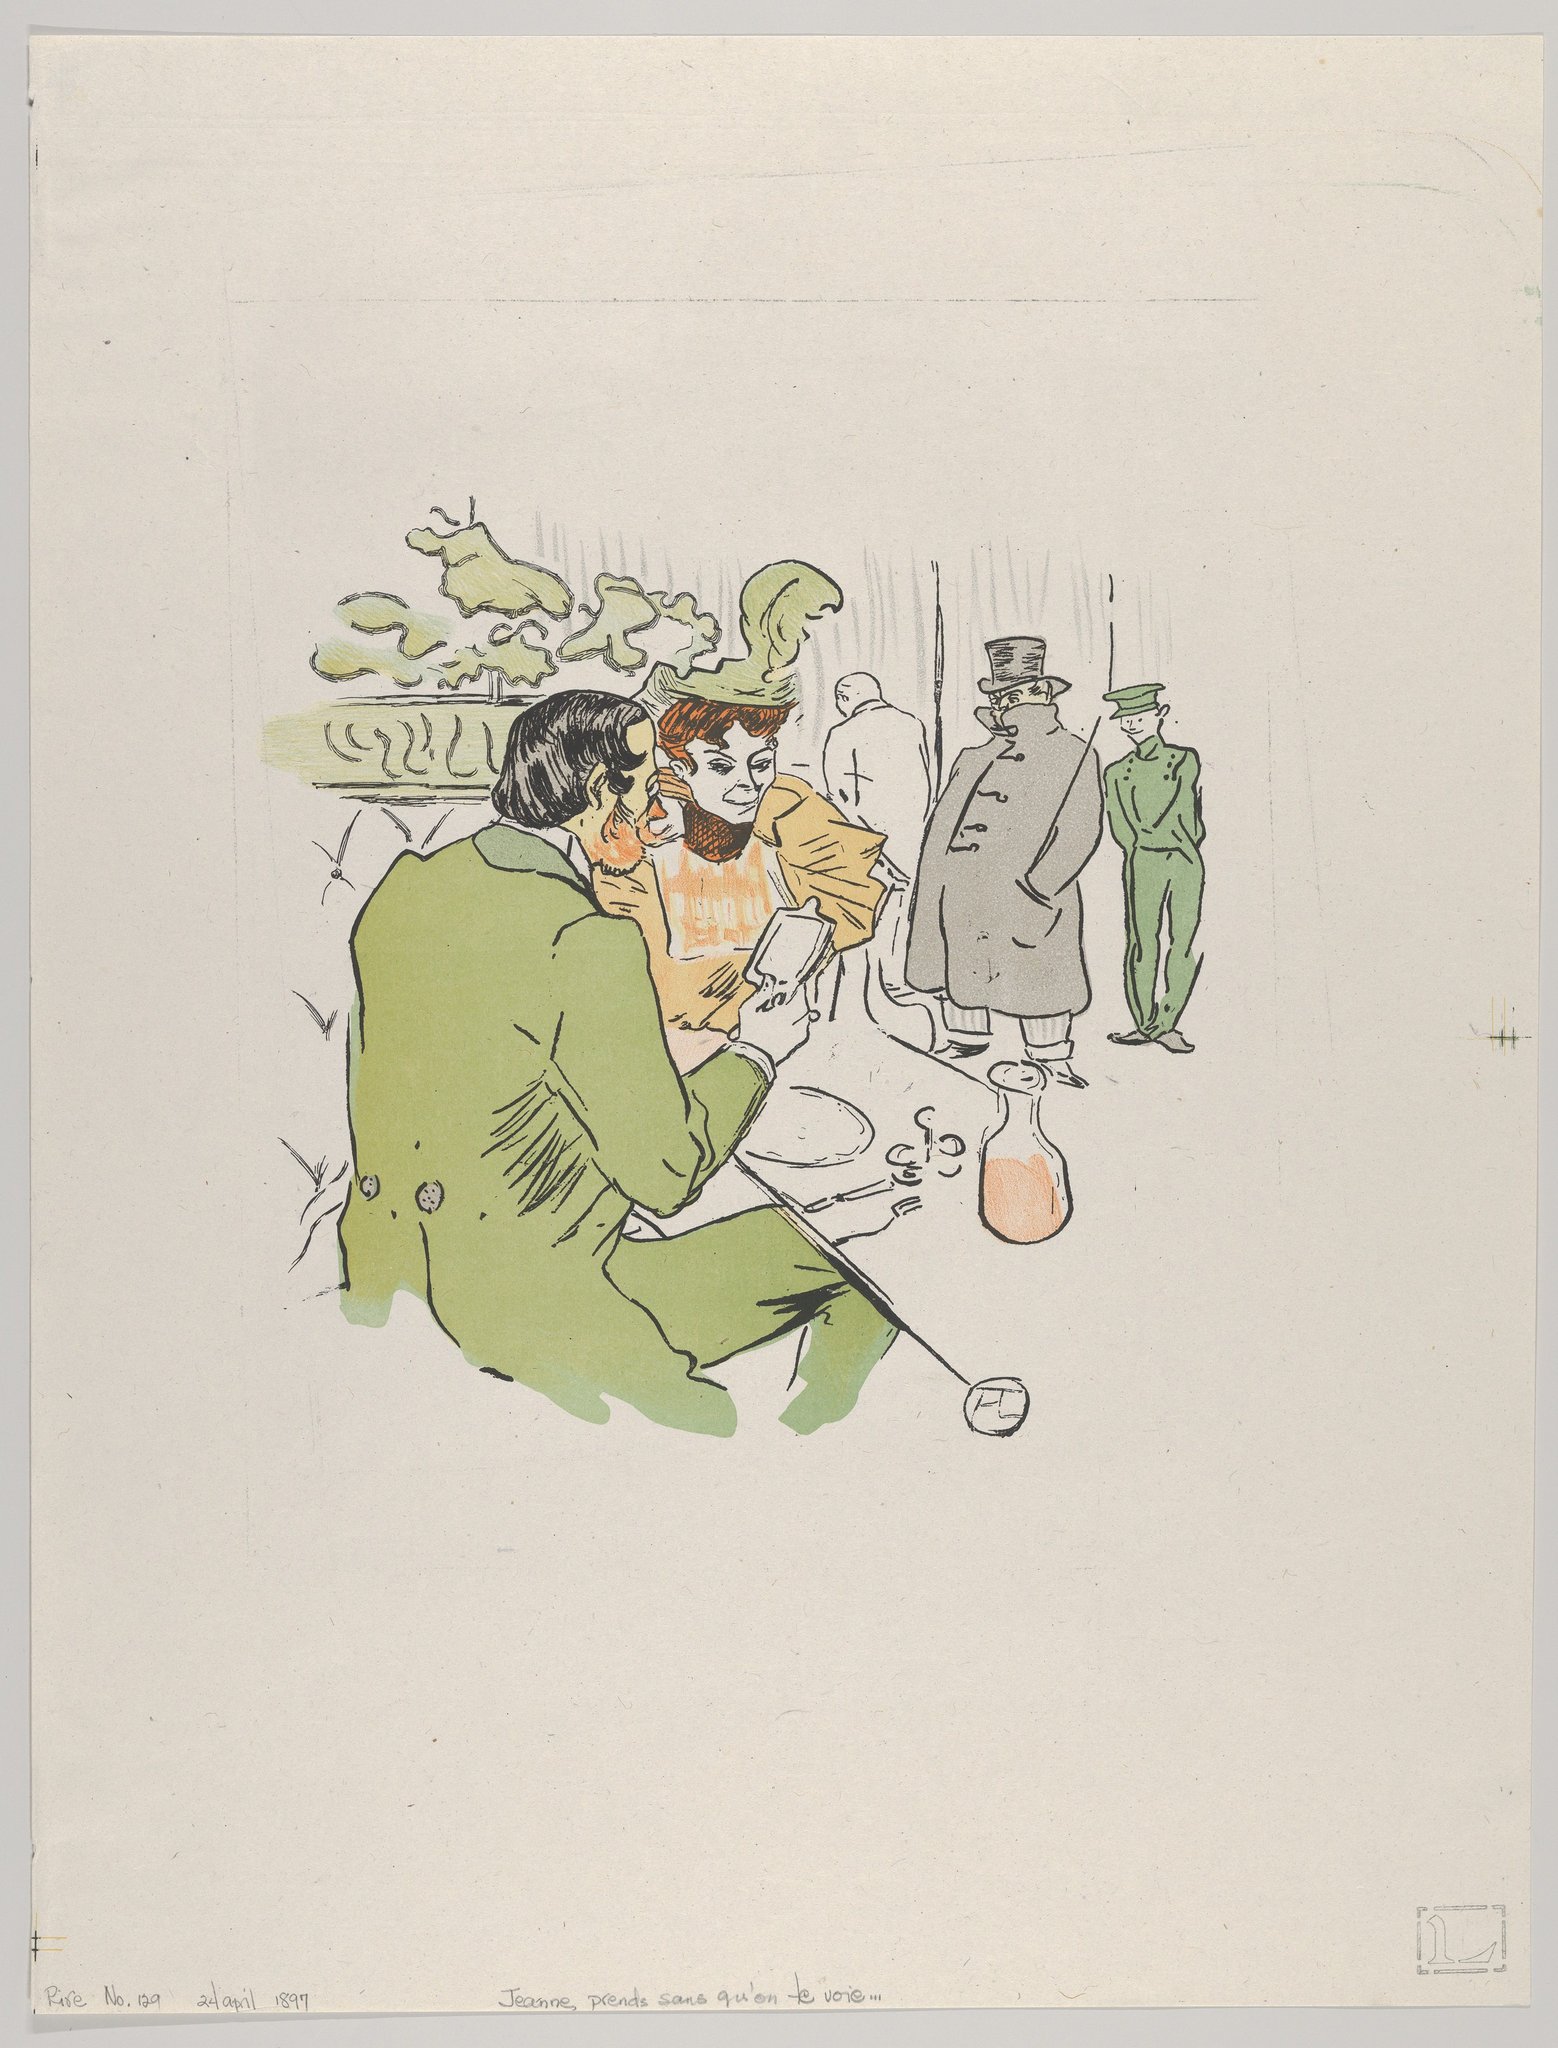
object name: print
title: Jeanne, prends sans qu'on te voie . . . , from Le Rire, No. 129, 24 April 1897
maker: henri de toulouse-lautrec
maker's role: artist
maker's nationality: french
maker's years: 1864-1901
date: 1897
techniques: lithograph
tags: men,women